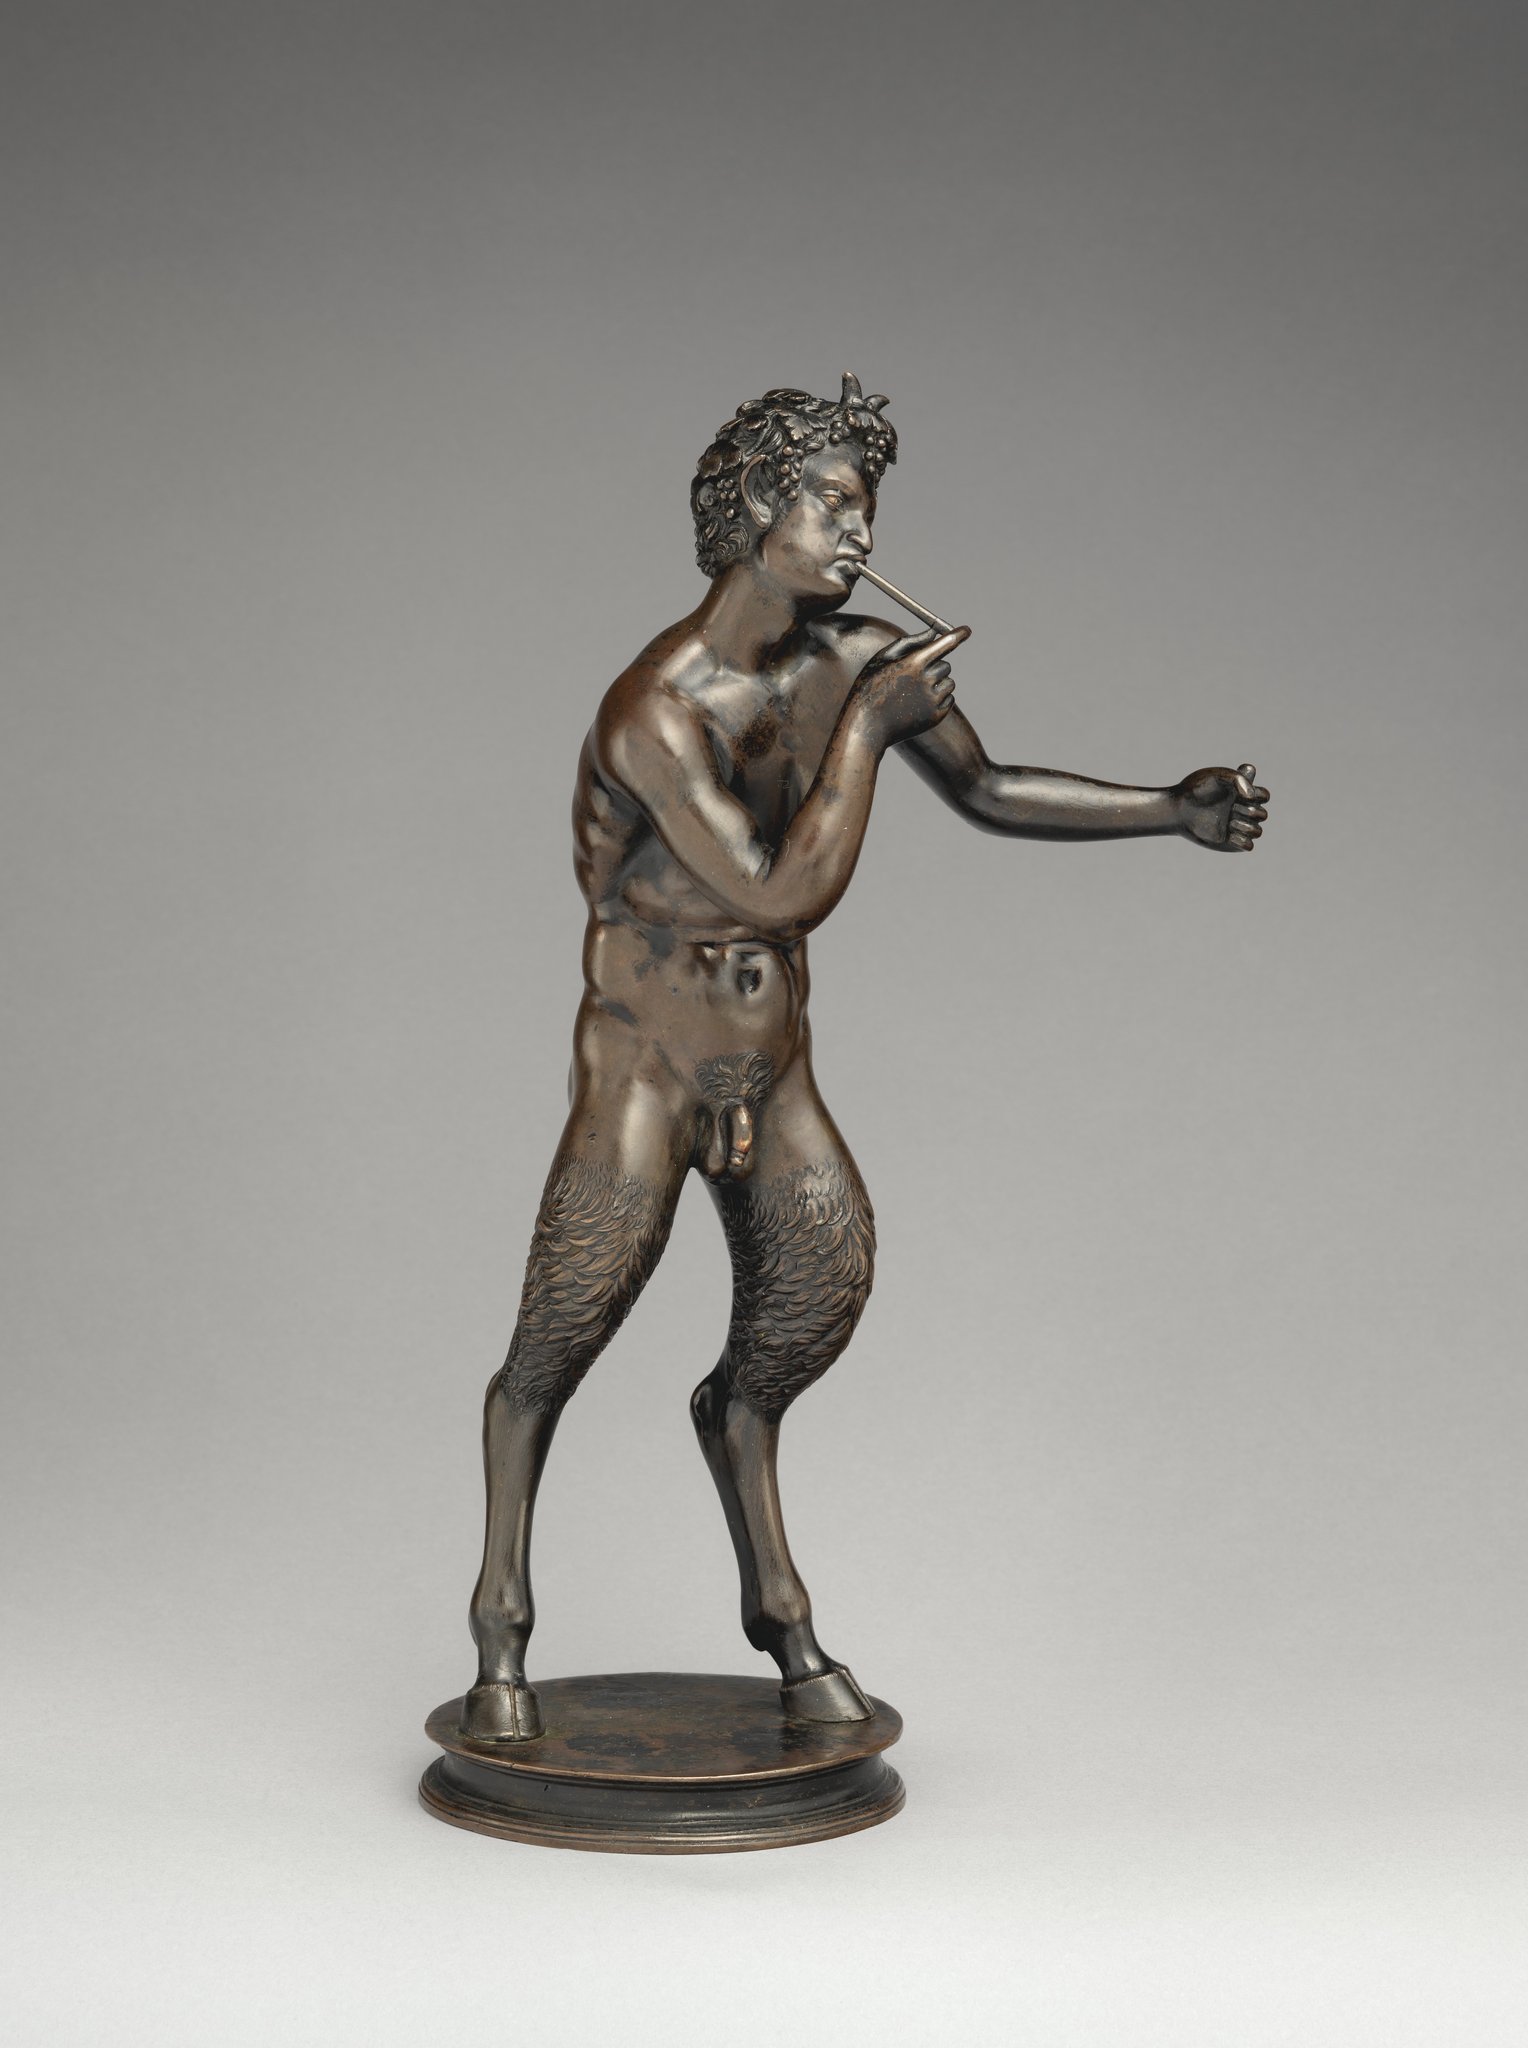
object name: statuette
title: Satyr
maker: antico (pier jacopo alari bonacolsi)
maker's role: artist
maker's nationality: italian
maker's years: 1460-1528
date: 1510-1520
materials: bronze, lacquer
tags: satyrs